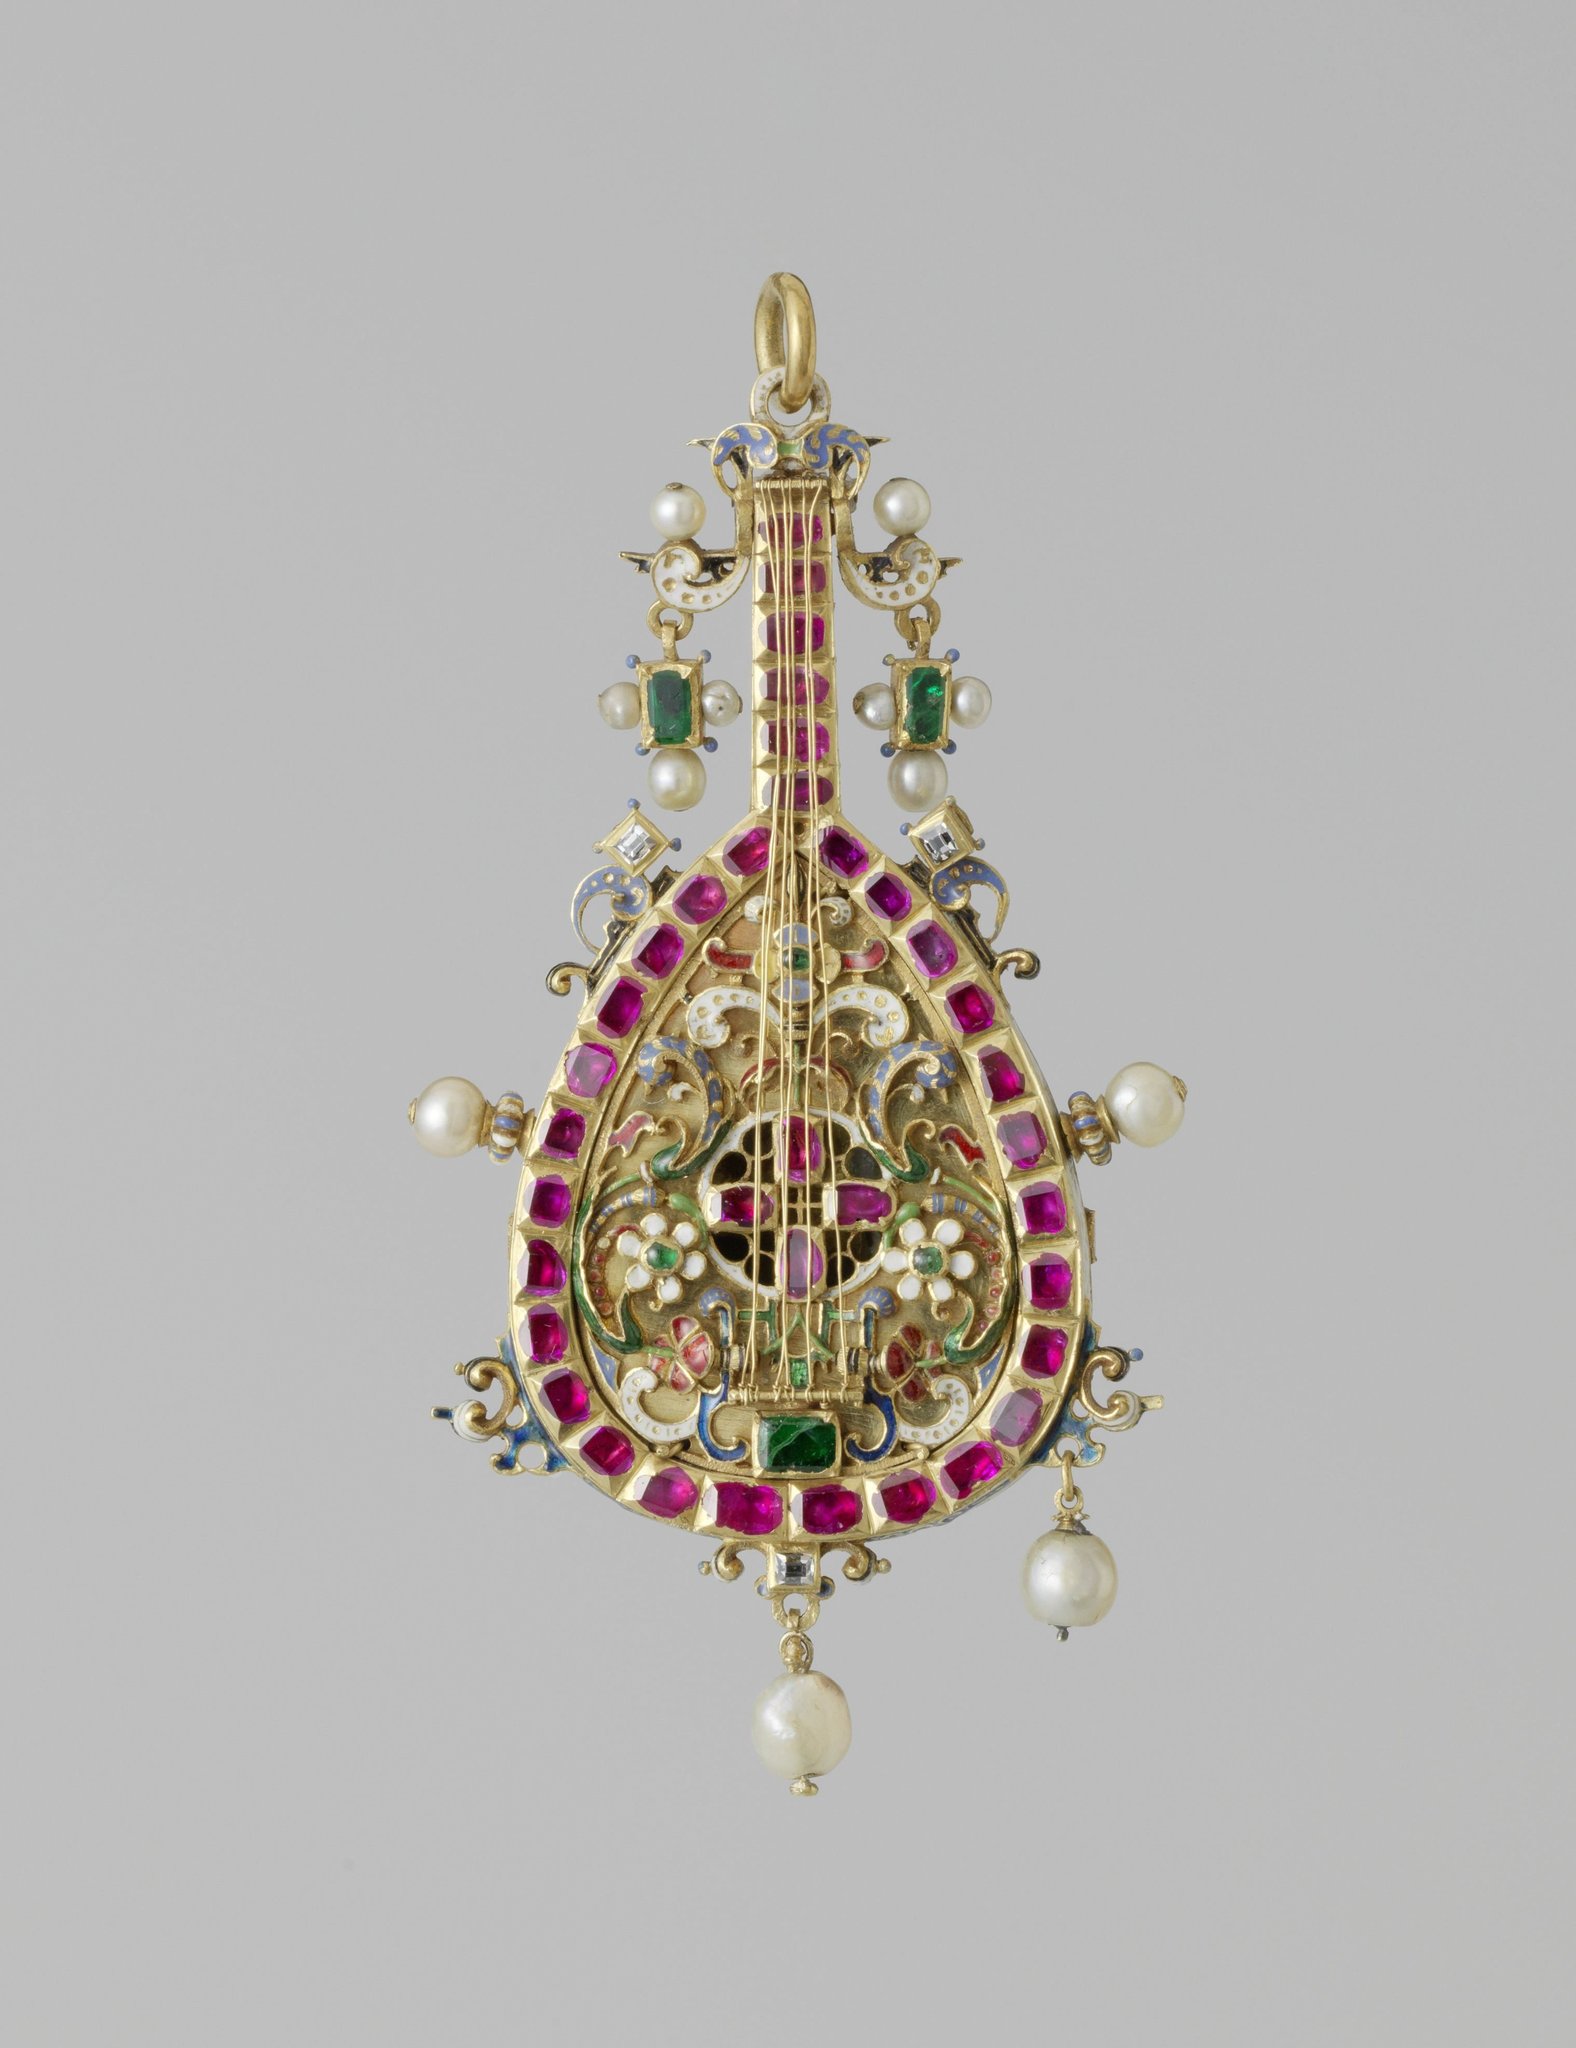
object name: pendant jewelry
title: Hanger in de vorm van een mandoline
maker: Anonymous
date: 1600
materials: gemstone, gold, pearl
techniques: enameling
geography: germany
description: Pendant, mandolin. Gold, rubies, emeralds, pearls and enamel. Germany or Italy, c. 1600.